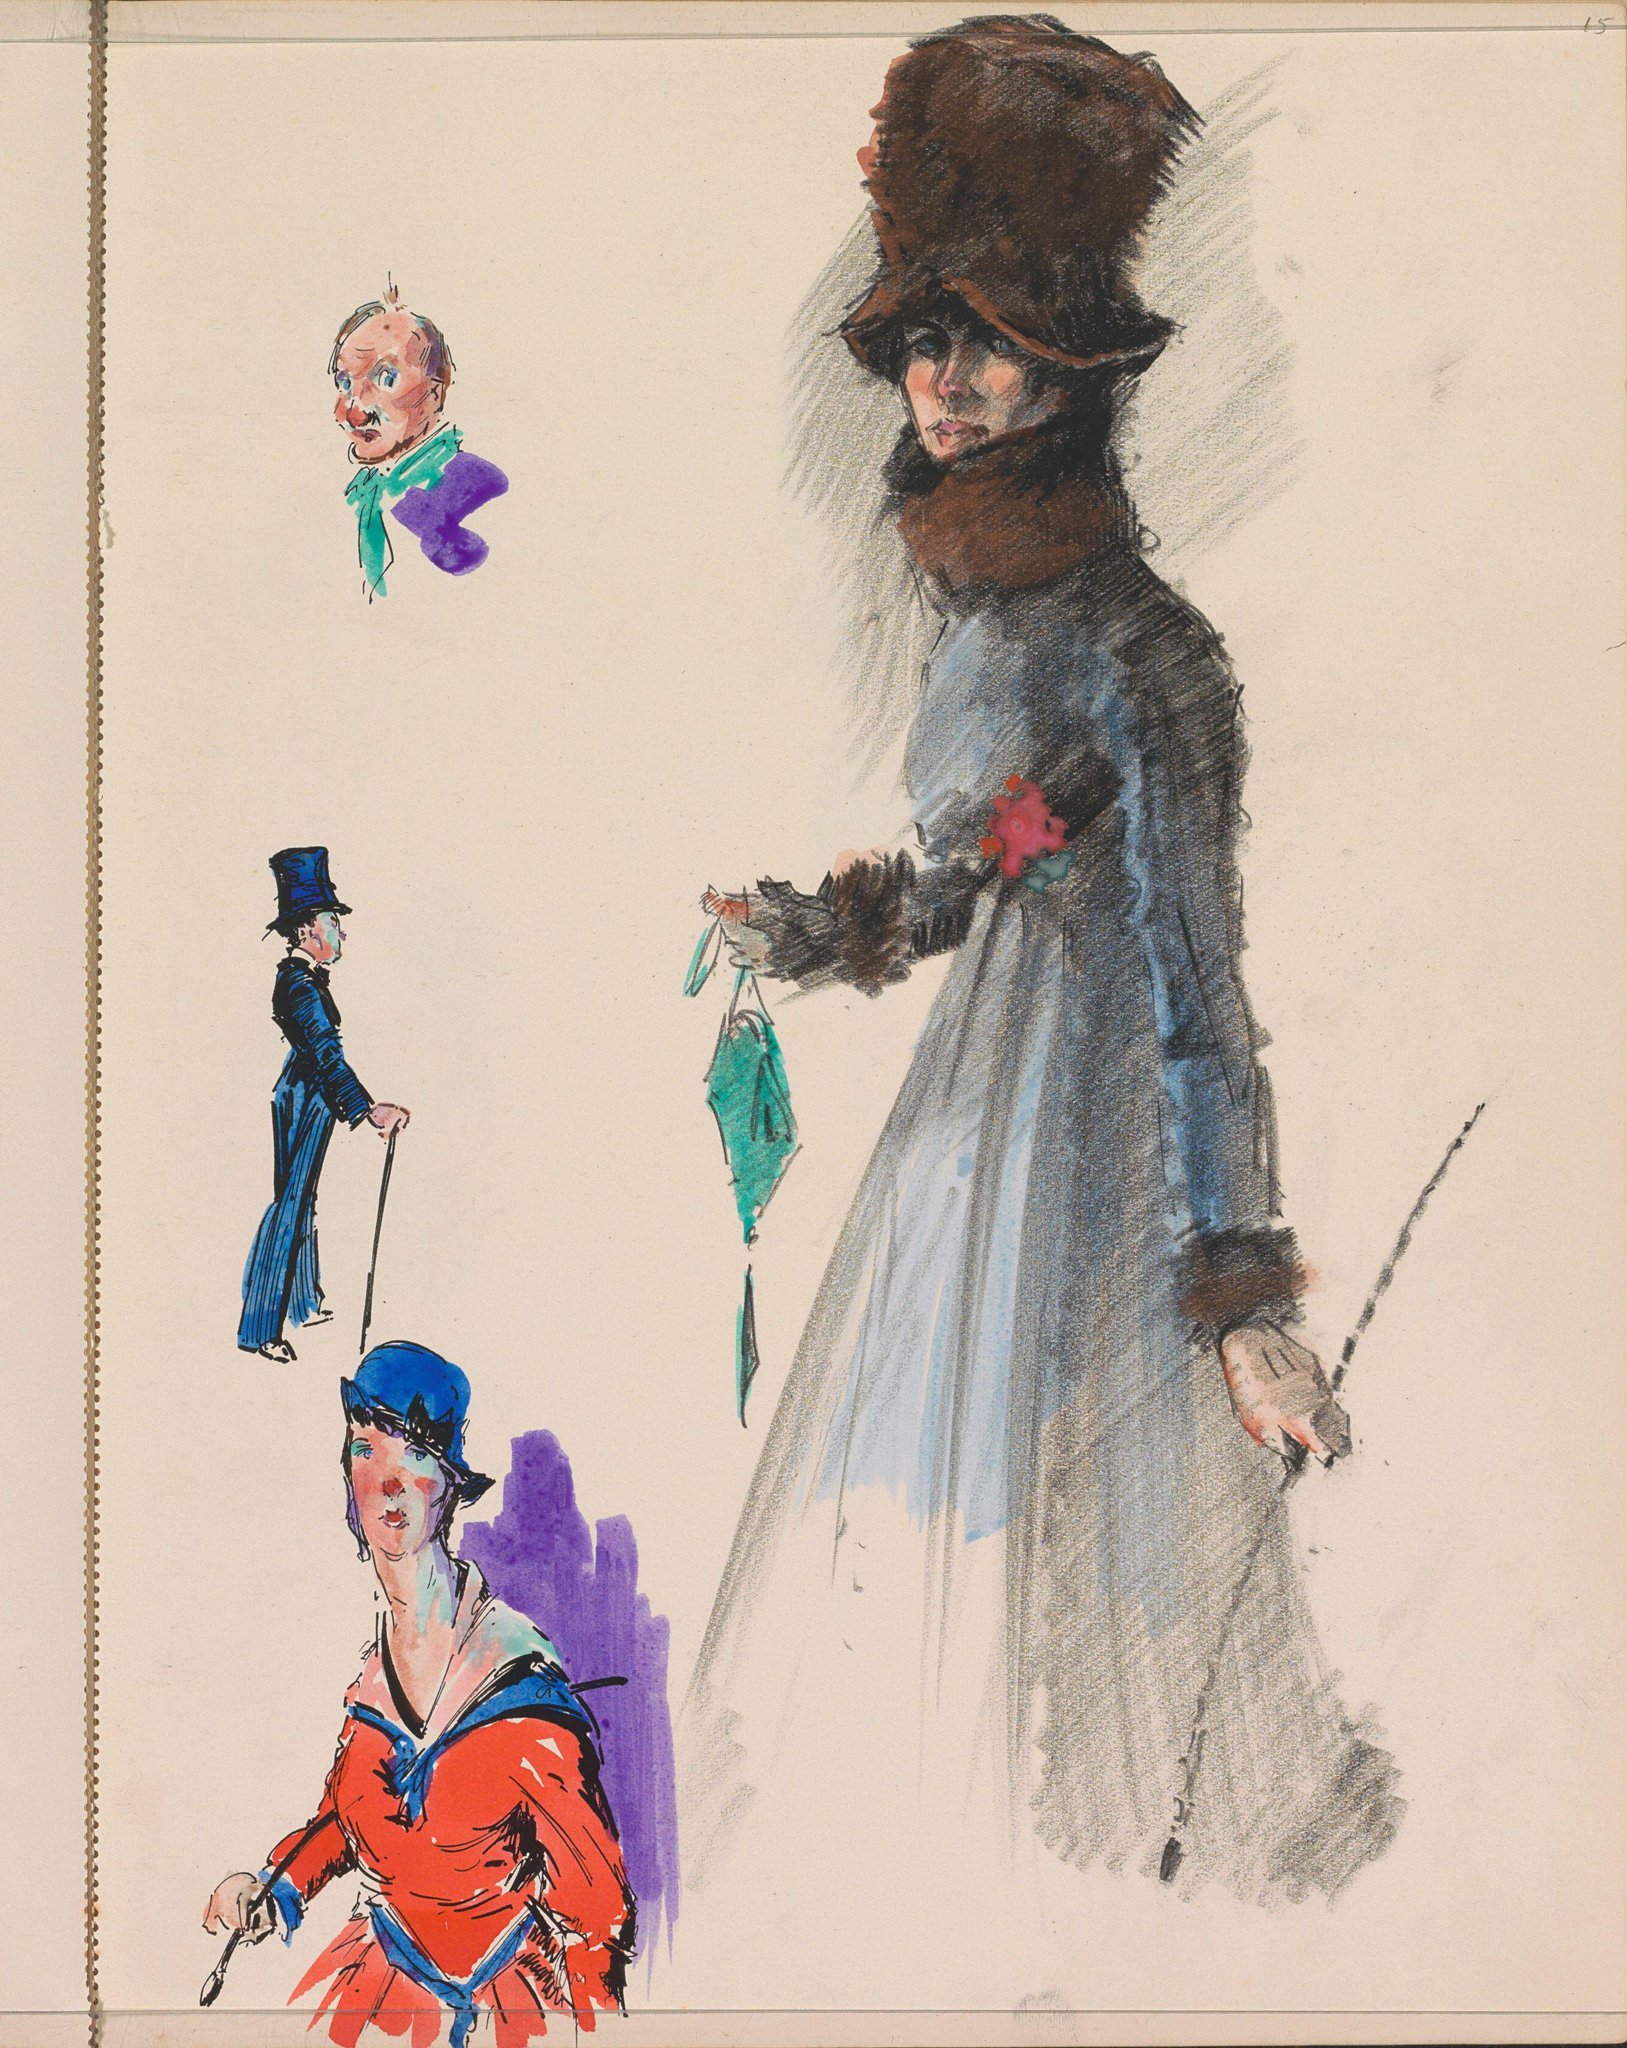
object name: sketchbook leaf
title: Wandelende vrouw in een met bont afgezette mantel met bontmuts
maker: otto verhagen (i)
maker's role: draughtsman, print maker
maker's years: 1885-1951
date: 1917-1919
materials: chalk, ink, paper, pencil, watercolor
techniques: brush, pen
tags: coat (+ women's clothes), head-gear: hat, walking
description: Tevens drie figuurstudies. Pagina 15 uit een schetsboek met 28 bladen.